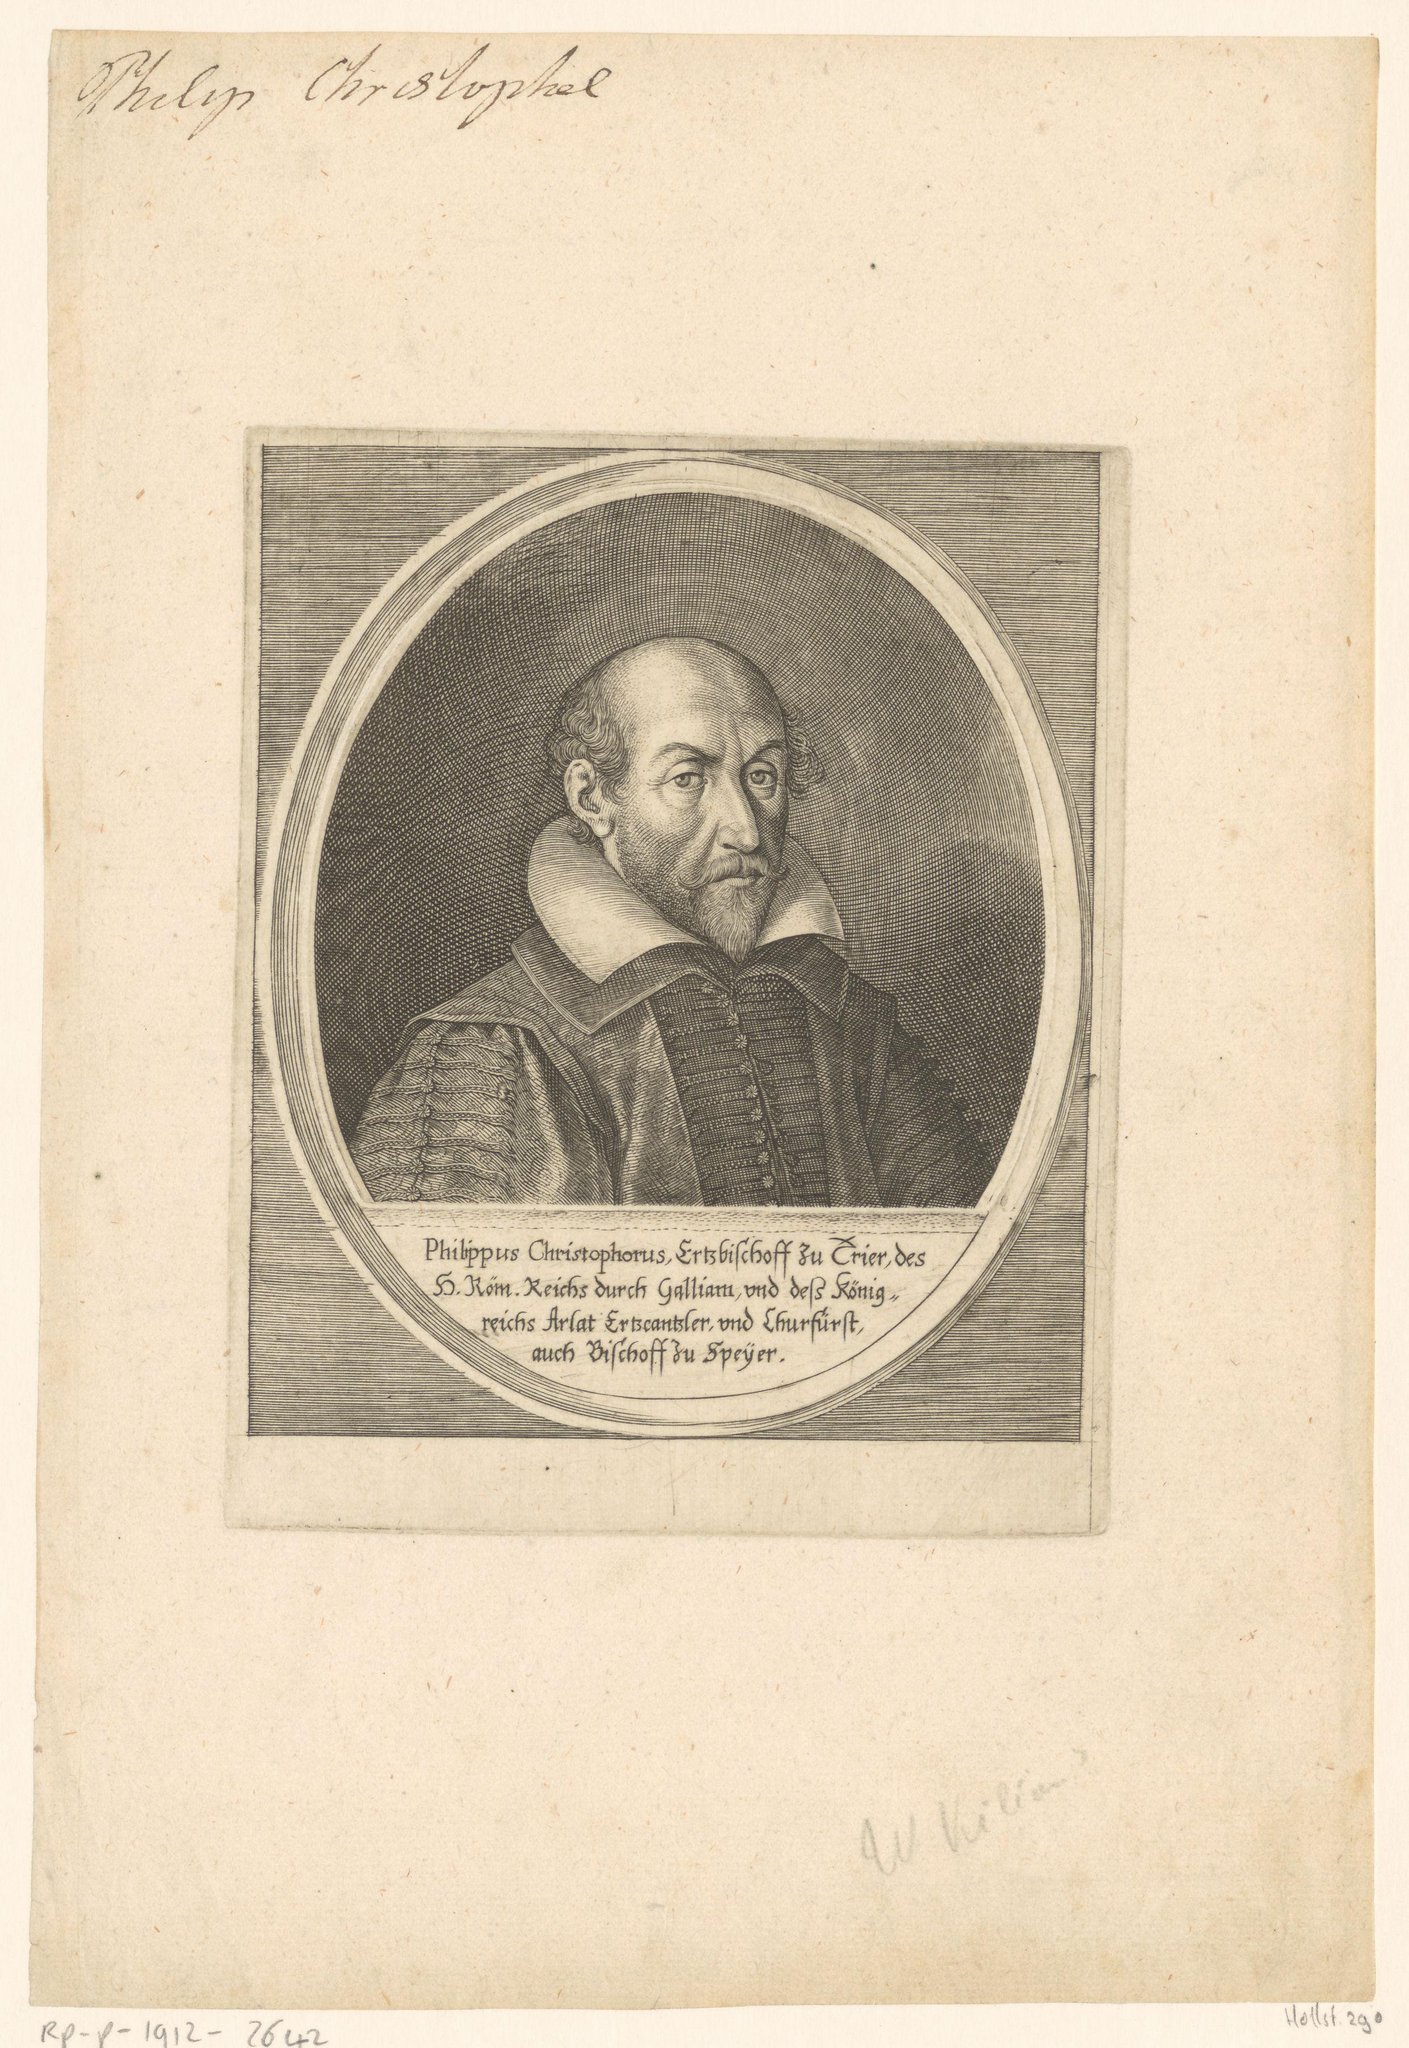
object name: print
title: Portret van Philipp Christoph von Sötern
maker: wolfgang kilian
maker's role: print maker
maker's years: 1581-1662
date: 1623-1662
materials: paper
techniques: engraving, etching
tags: archbishop, bishop, etc. (roman catholic), historical persons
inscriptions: collector's mark: Lugt 2228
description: Er bestaat een afdruk van de complete plaat van het portret in de Porträtsammlung der Herzog August Bibliothek Wolfenbüttel: A 28278.